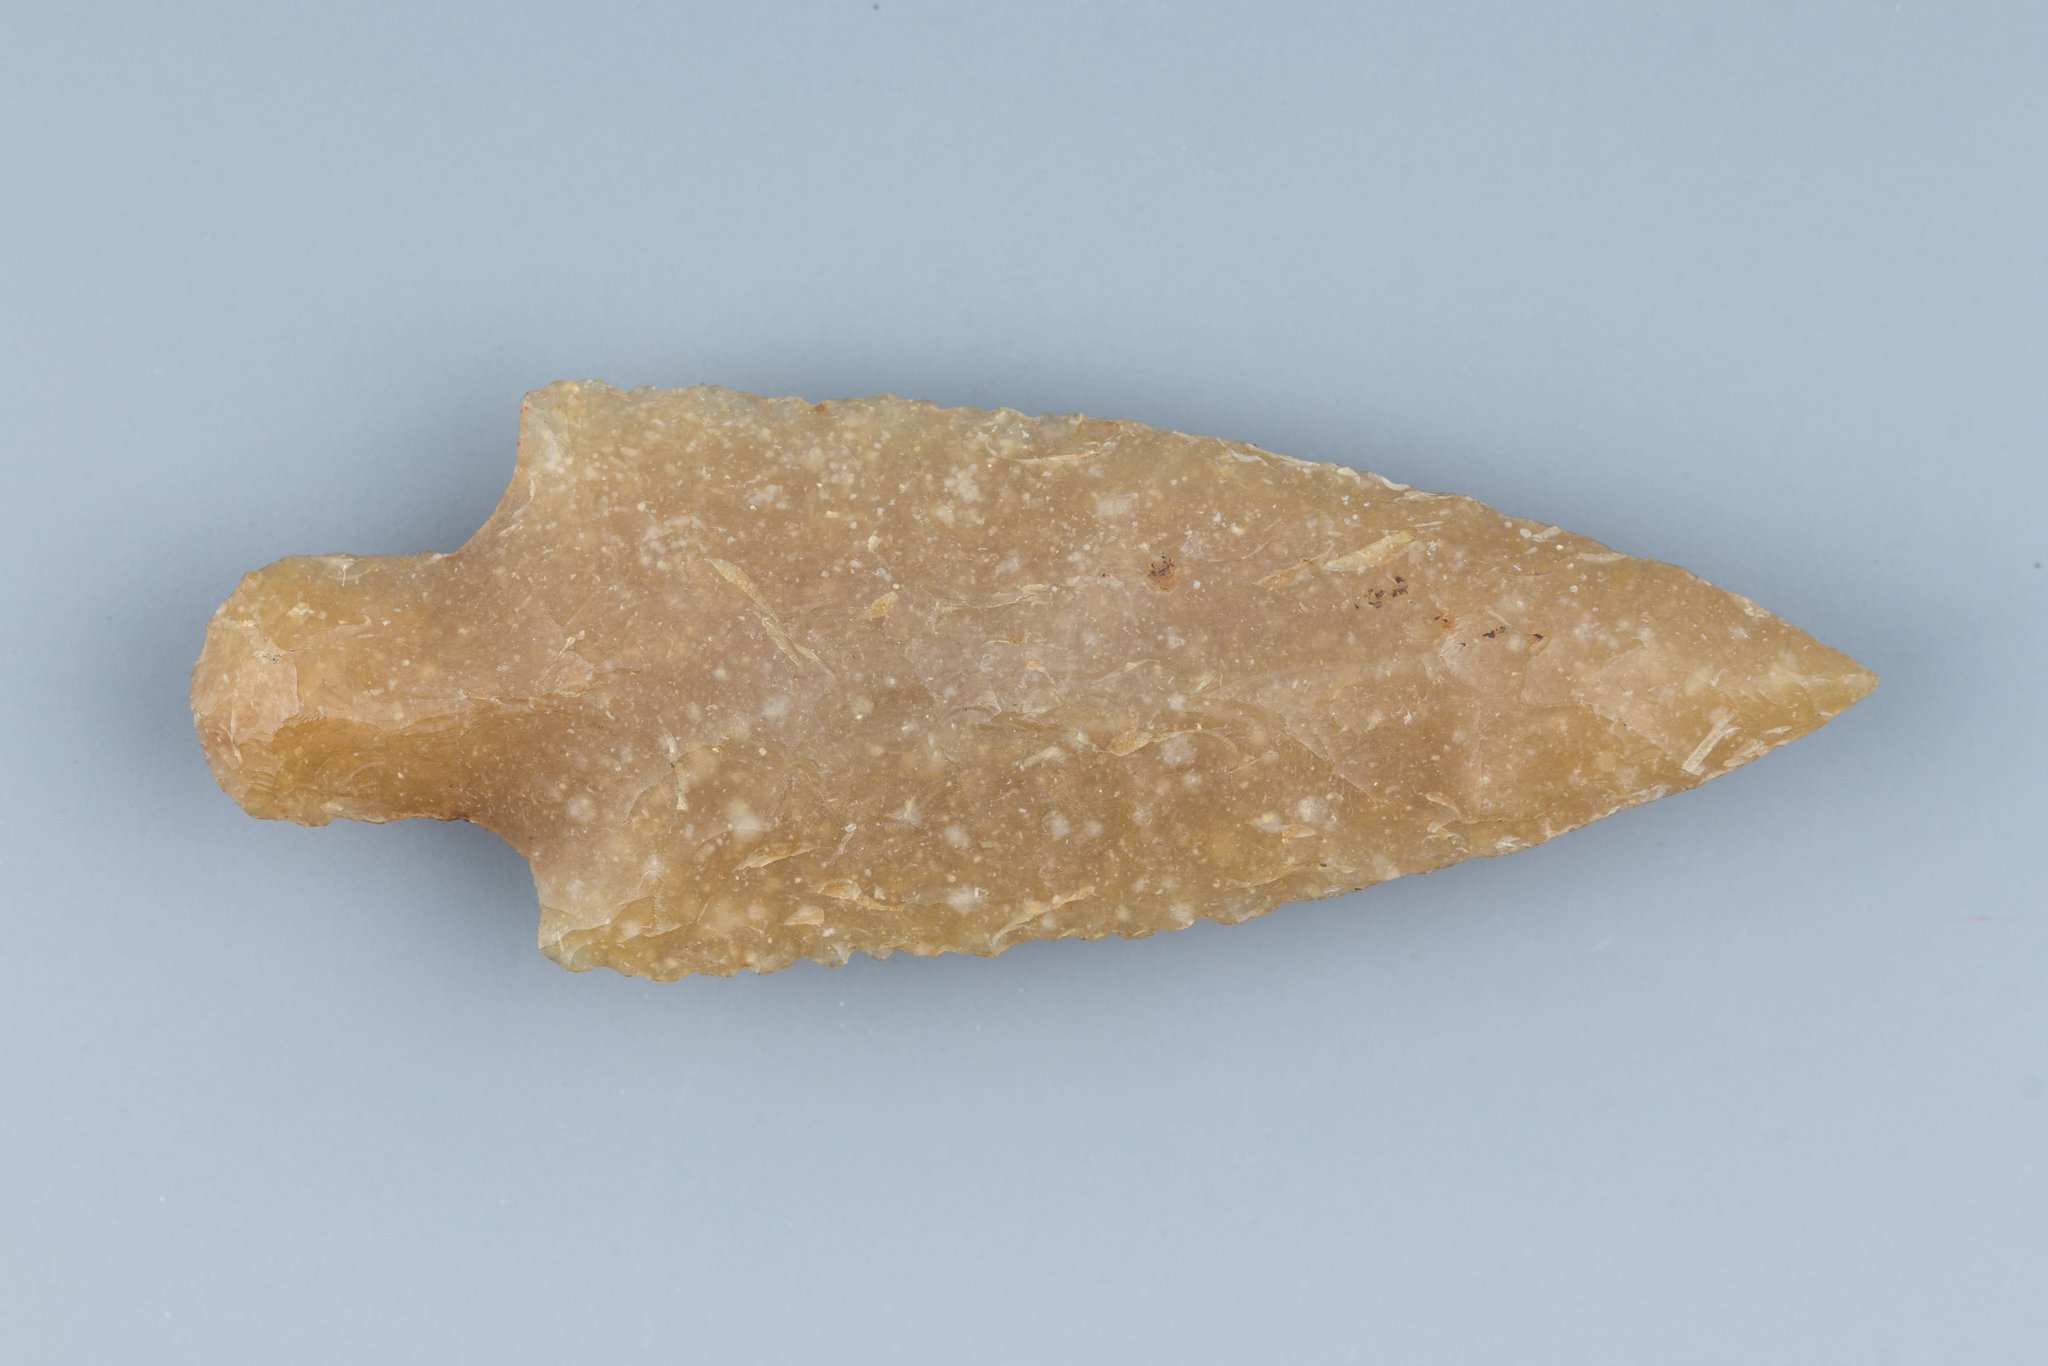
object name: arrowhead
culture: italian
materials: stone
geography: italy